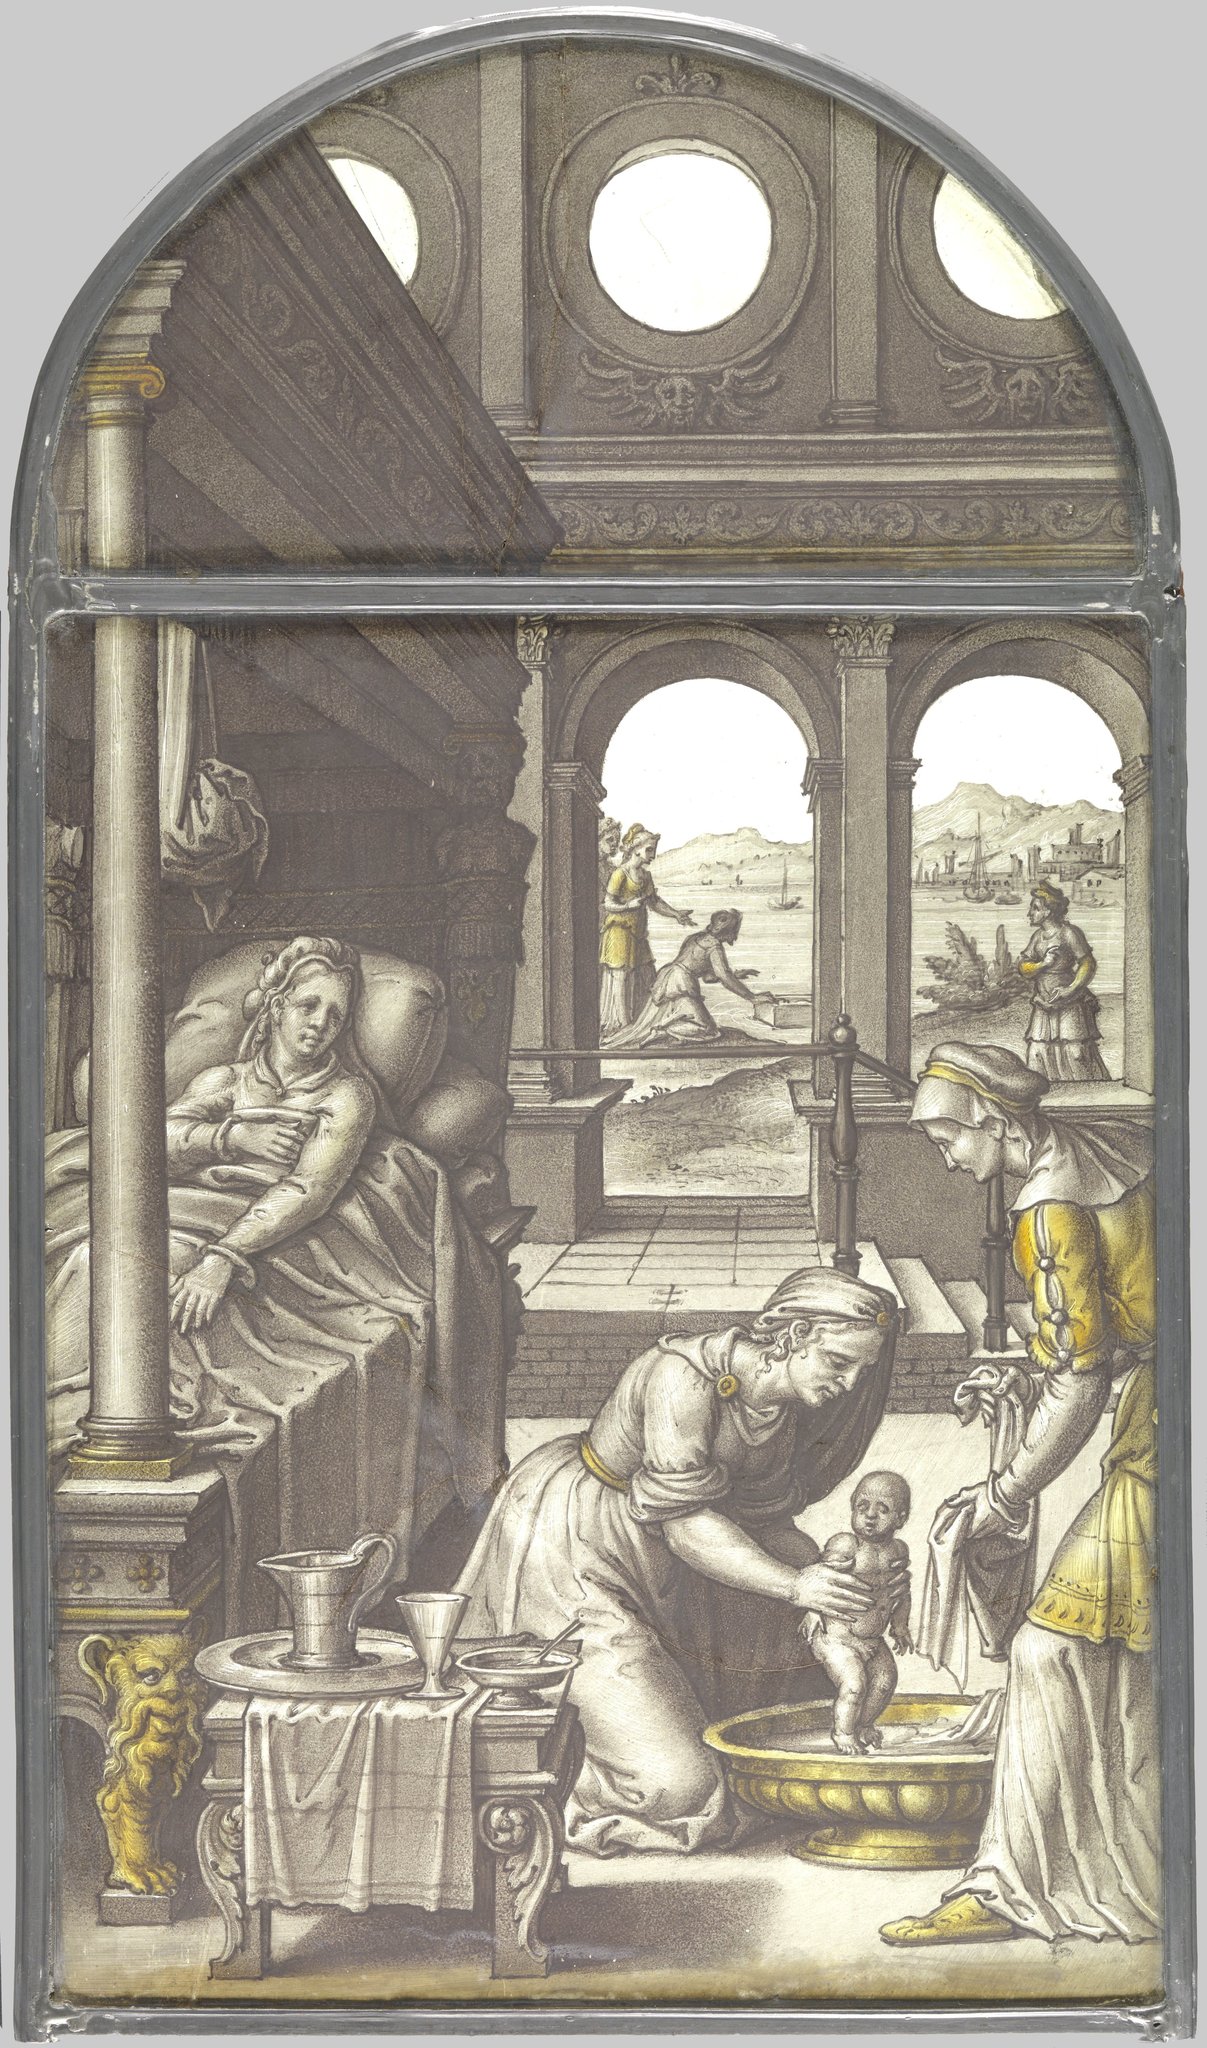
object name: stained glass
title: Geboorte van Mozes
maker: dirck pietersz. crabeth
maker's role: draughtsman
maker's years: 1520-1574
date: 1550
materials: glass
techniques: enamel painting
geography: antwerp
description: De Geboorte van Mozes (Exodus 2) bestaat uit twee onderdelen. Een rechthoekig glaspaneel met de hoofdvoorstelling erop en een kleiner paneel met een ronde bovenkant waarop de architectuur van het grote paneel doorloopt. Links op het grote paneel ligt de moeder van Mozes in het kraambed, rechts wordt het kindje gewassen. Op de achtergrond de scène waar Mozes, verstopt in een mandje, in de Nijl wordt gezet.